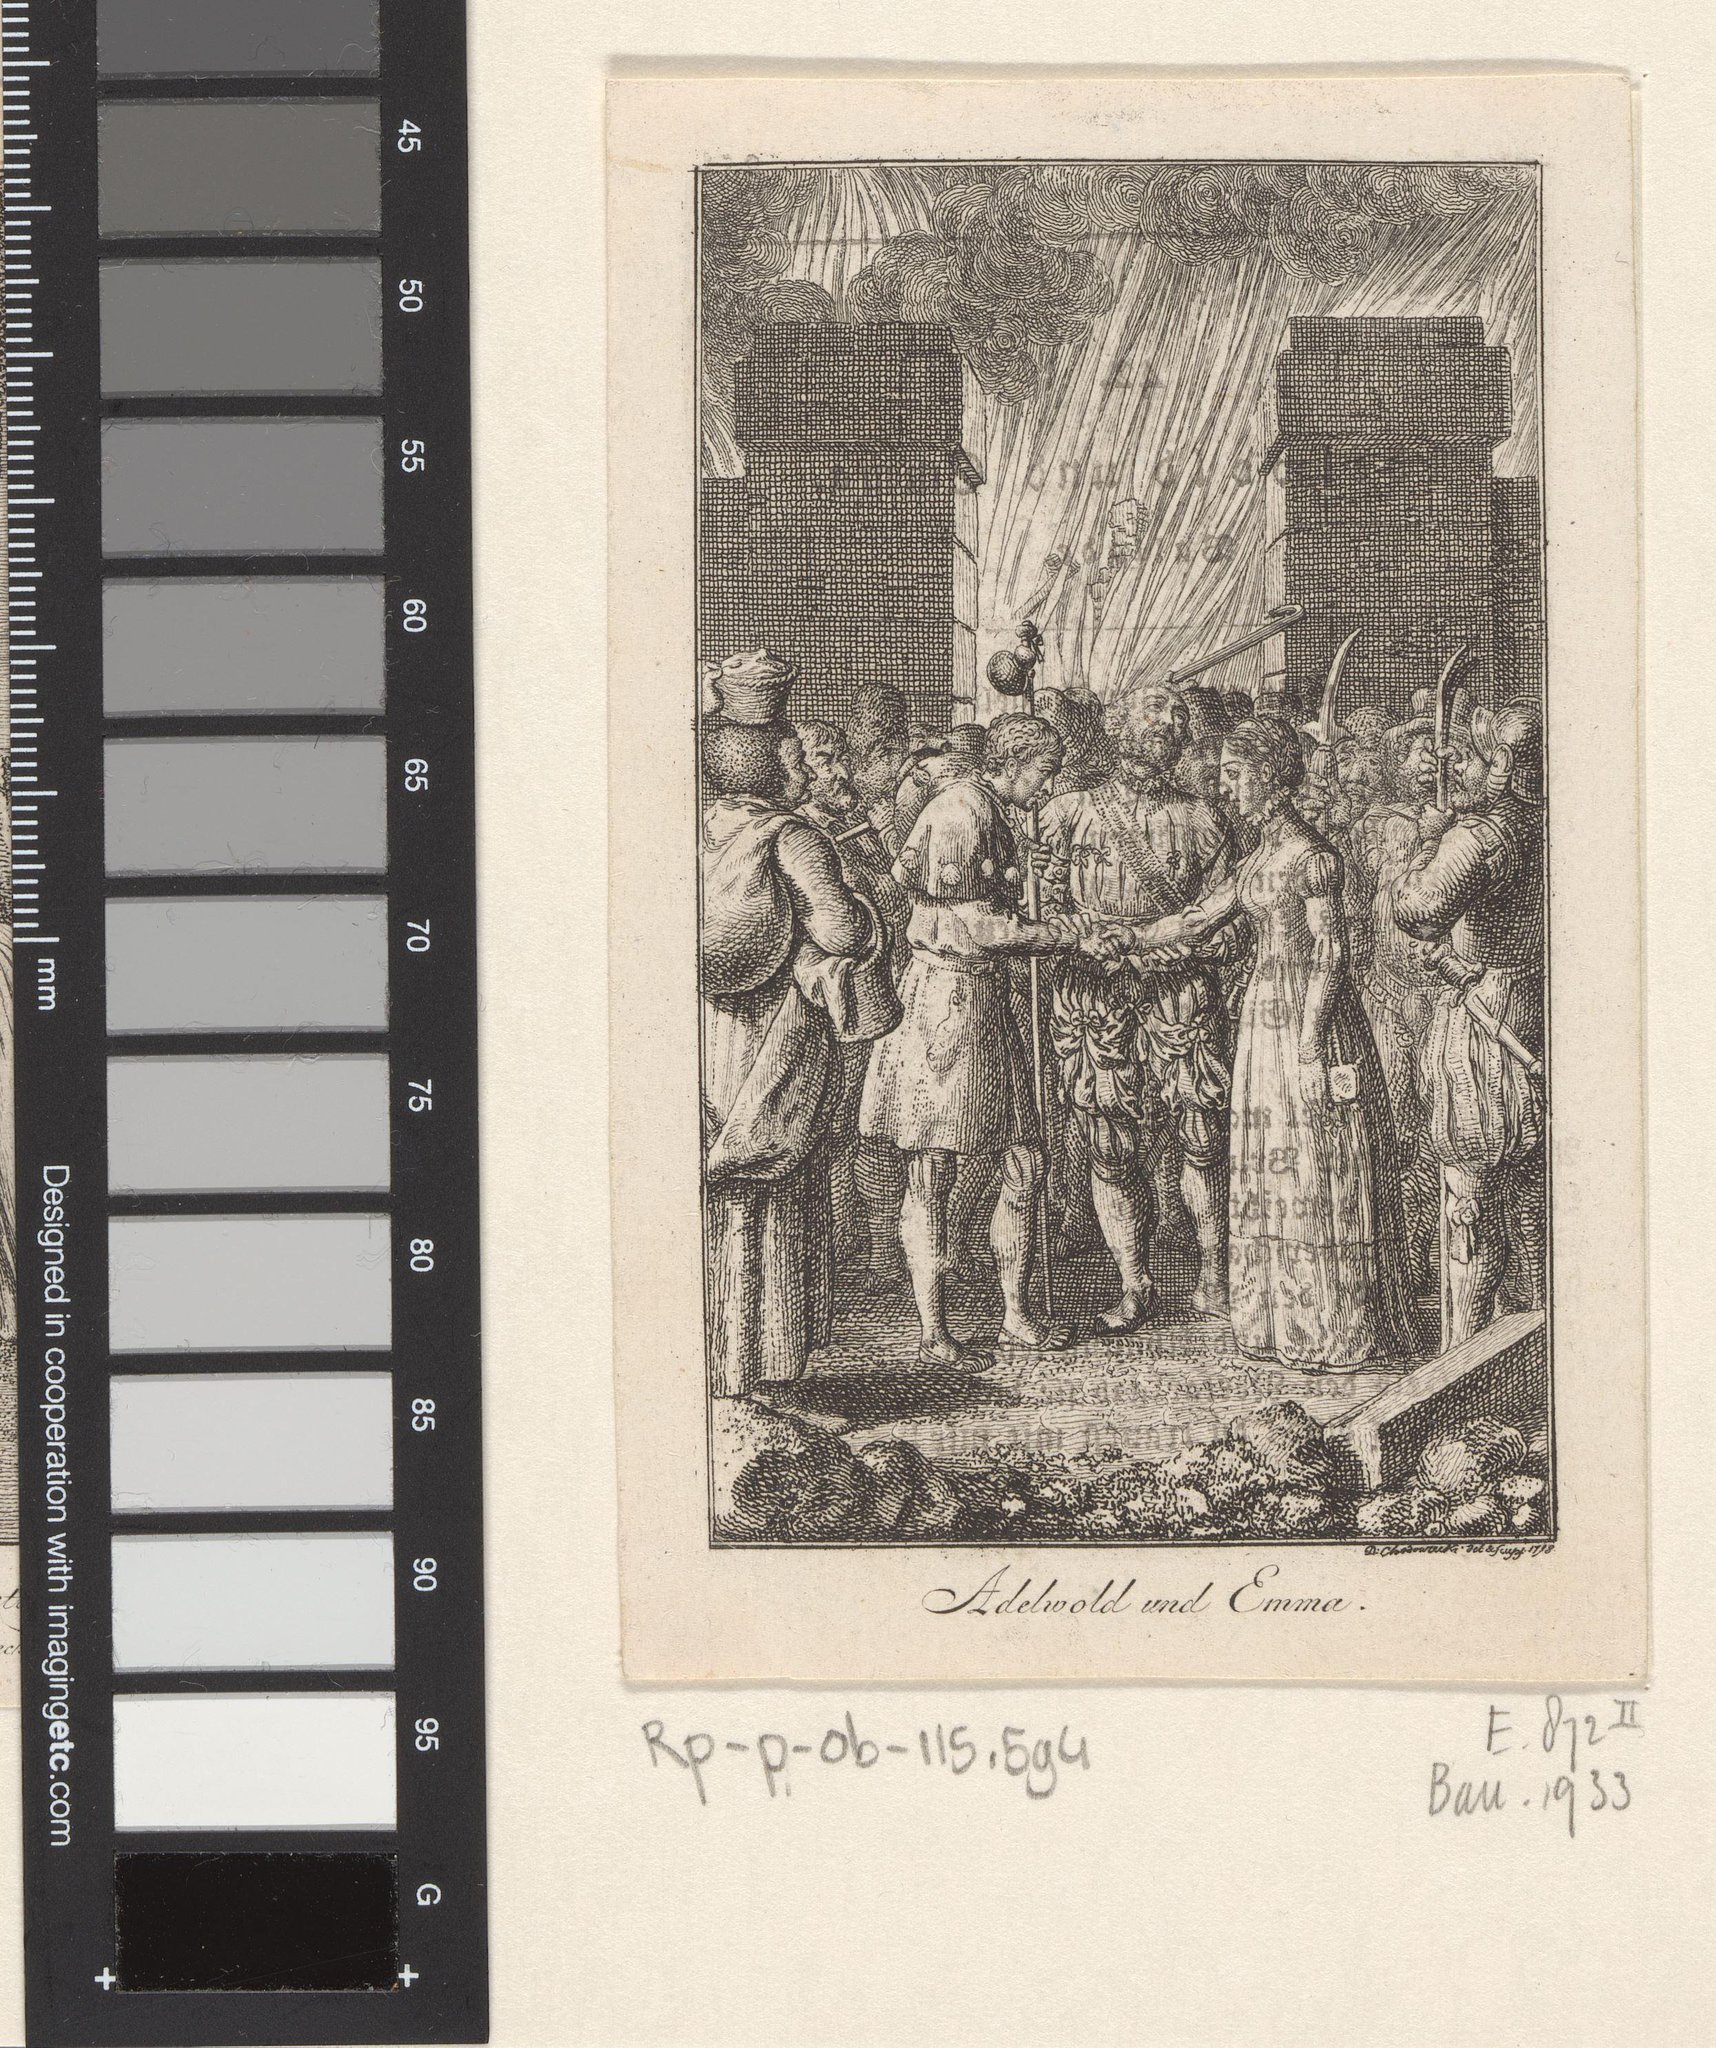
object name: print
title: Adelwold en Emma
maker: daniel nikolaus chodowiecki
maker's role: draughtsman, print maker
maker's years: 1726-1801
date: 1797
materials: paper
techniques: etching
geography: berlin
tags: on fire, ablaze, pilgrim(s)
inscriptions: collector's mark: Lugt 2228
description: Latere staat gebruikt voor het verhaal 'Die glückliche Rettung' in: Becker, Wilhelm Gottlieb. Almanach und Taschenbuch zum geselligen Vergnügen von W. G. Becker für 1799. Leipzig: Voss und Comp., 1798. De in boekdruk gedrukte teksten van de volgende en voorgaande pagina's hebben afgegeven op de recto en verso van deze prent. Daardoor is tekst in spiegelbeeld door de prent heen te lezen.